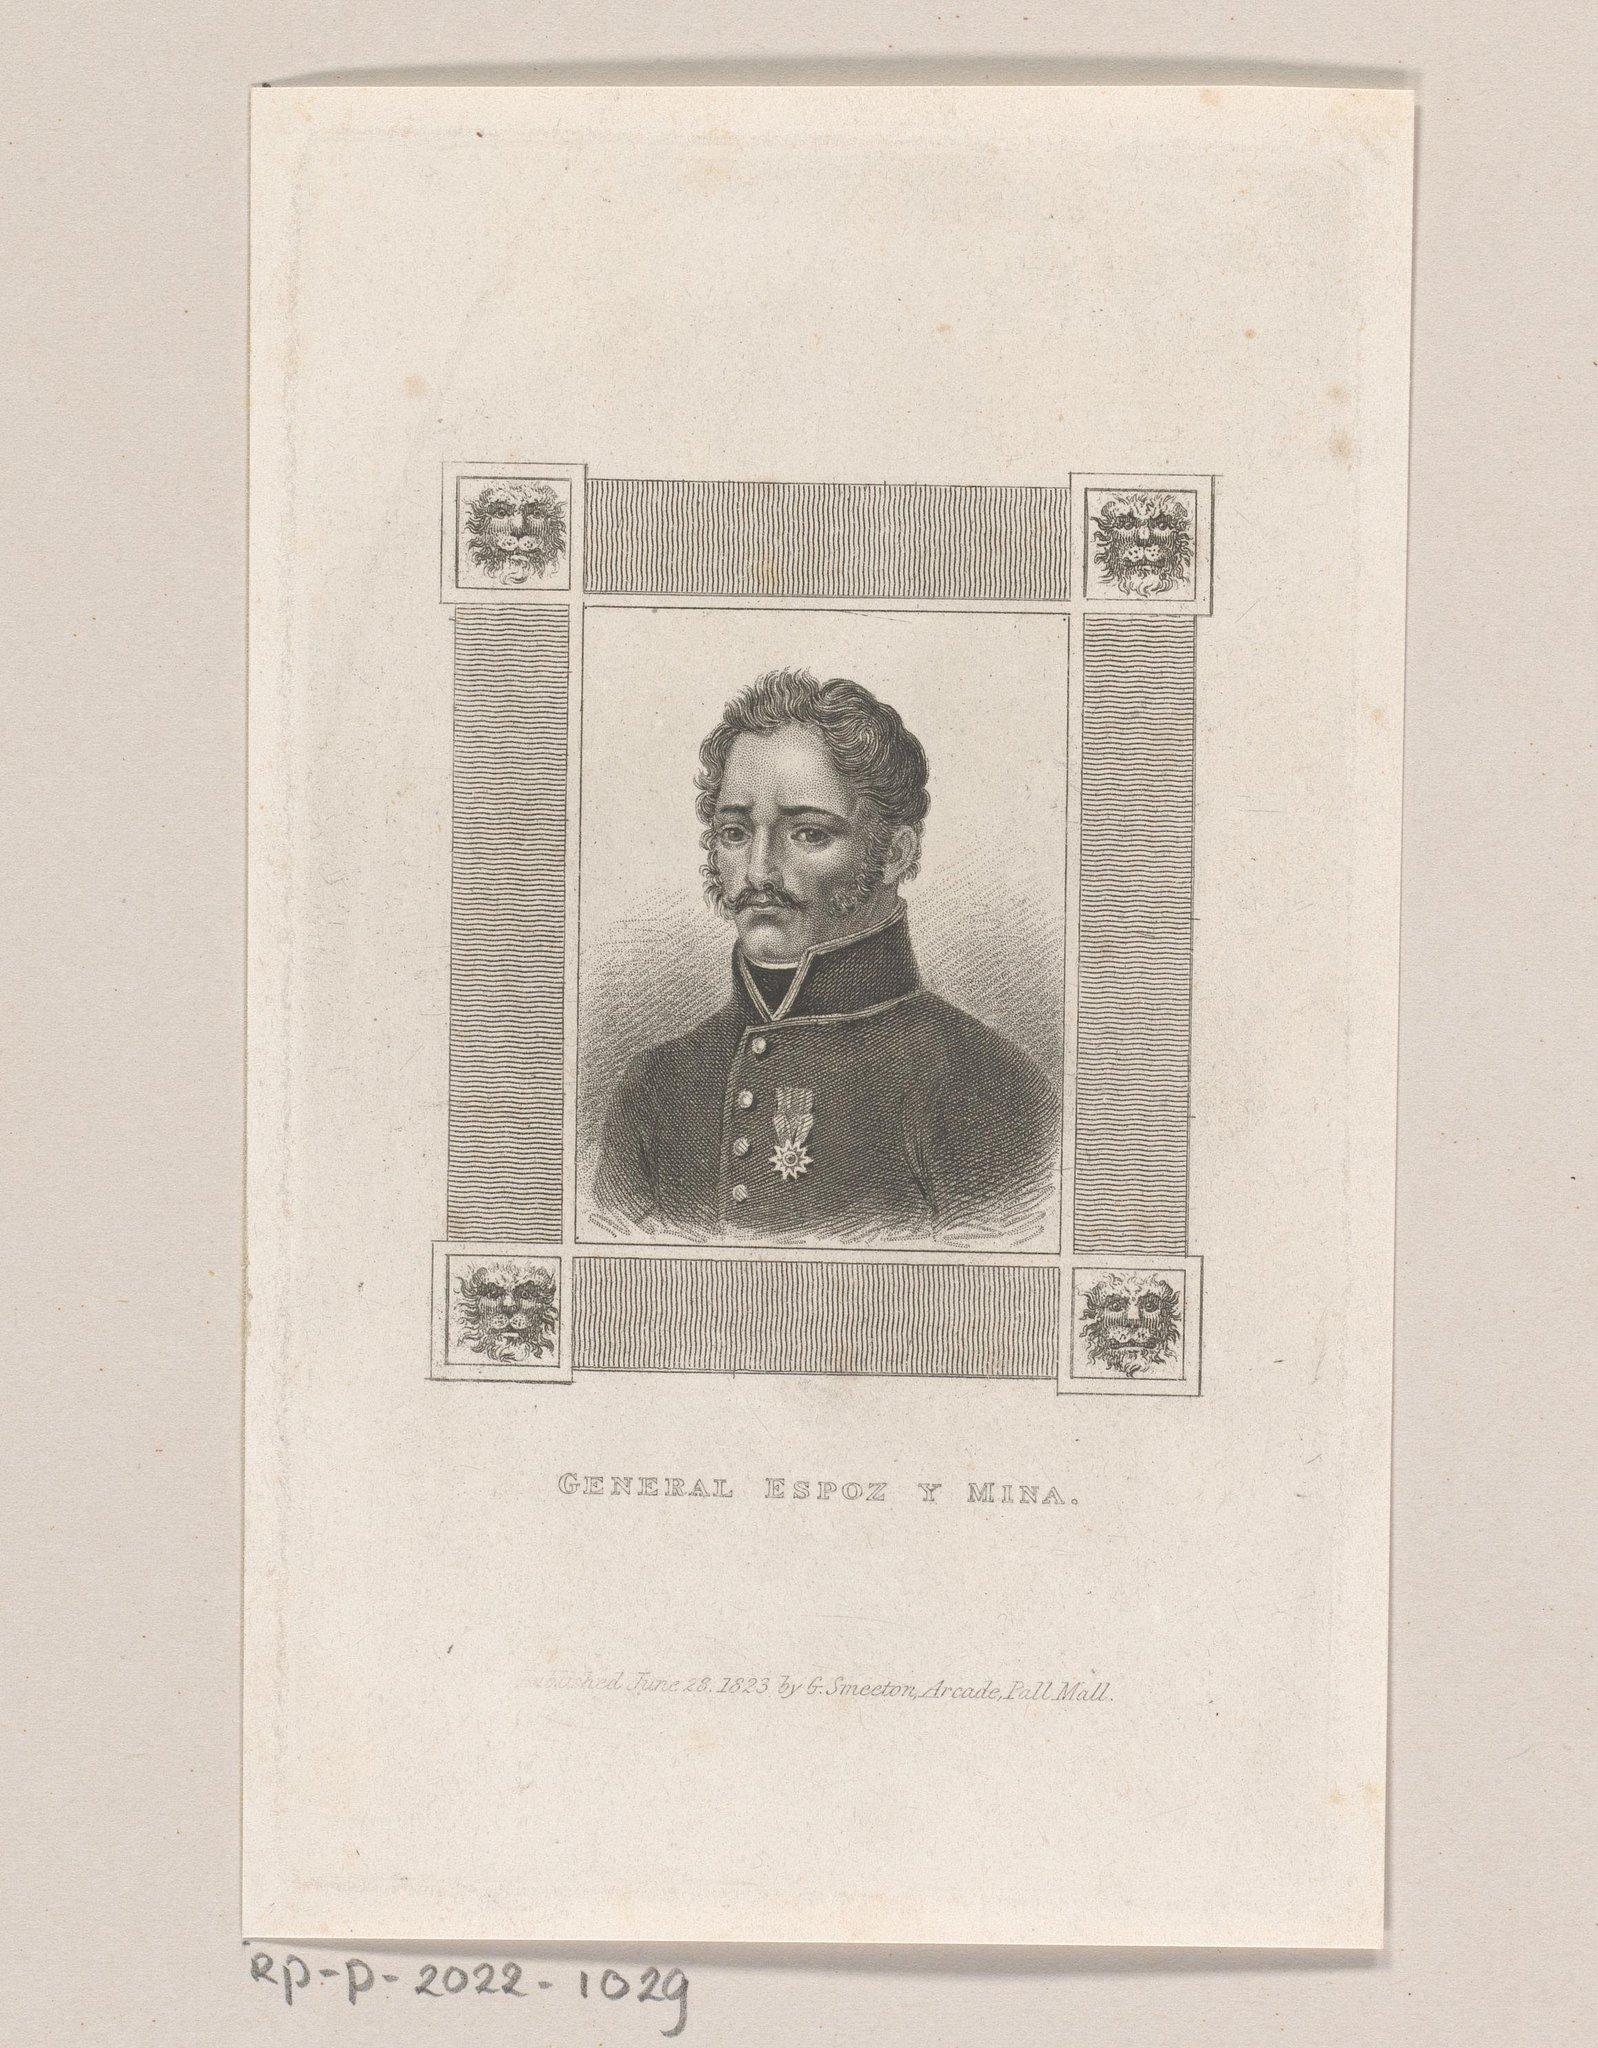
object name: print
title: General Espoz y Mina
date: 1823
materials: paper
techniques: etching, roulette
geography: london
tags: commander-in-chief, general, marshal, historical persons